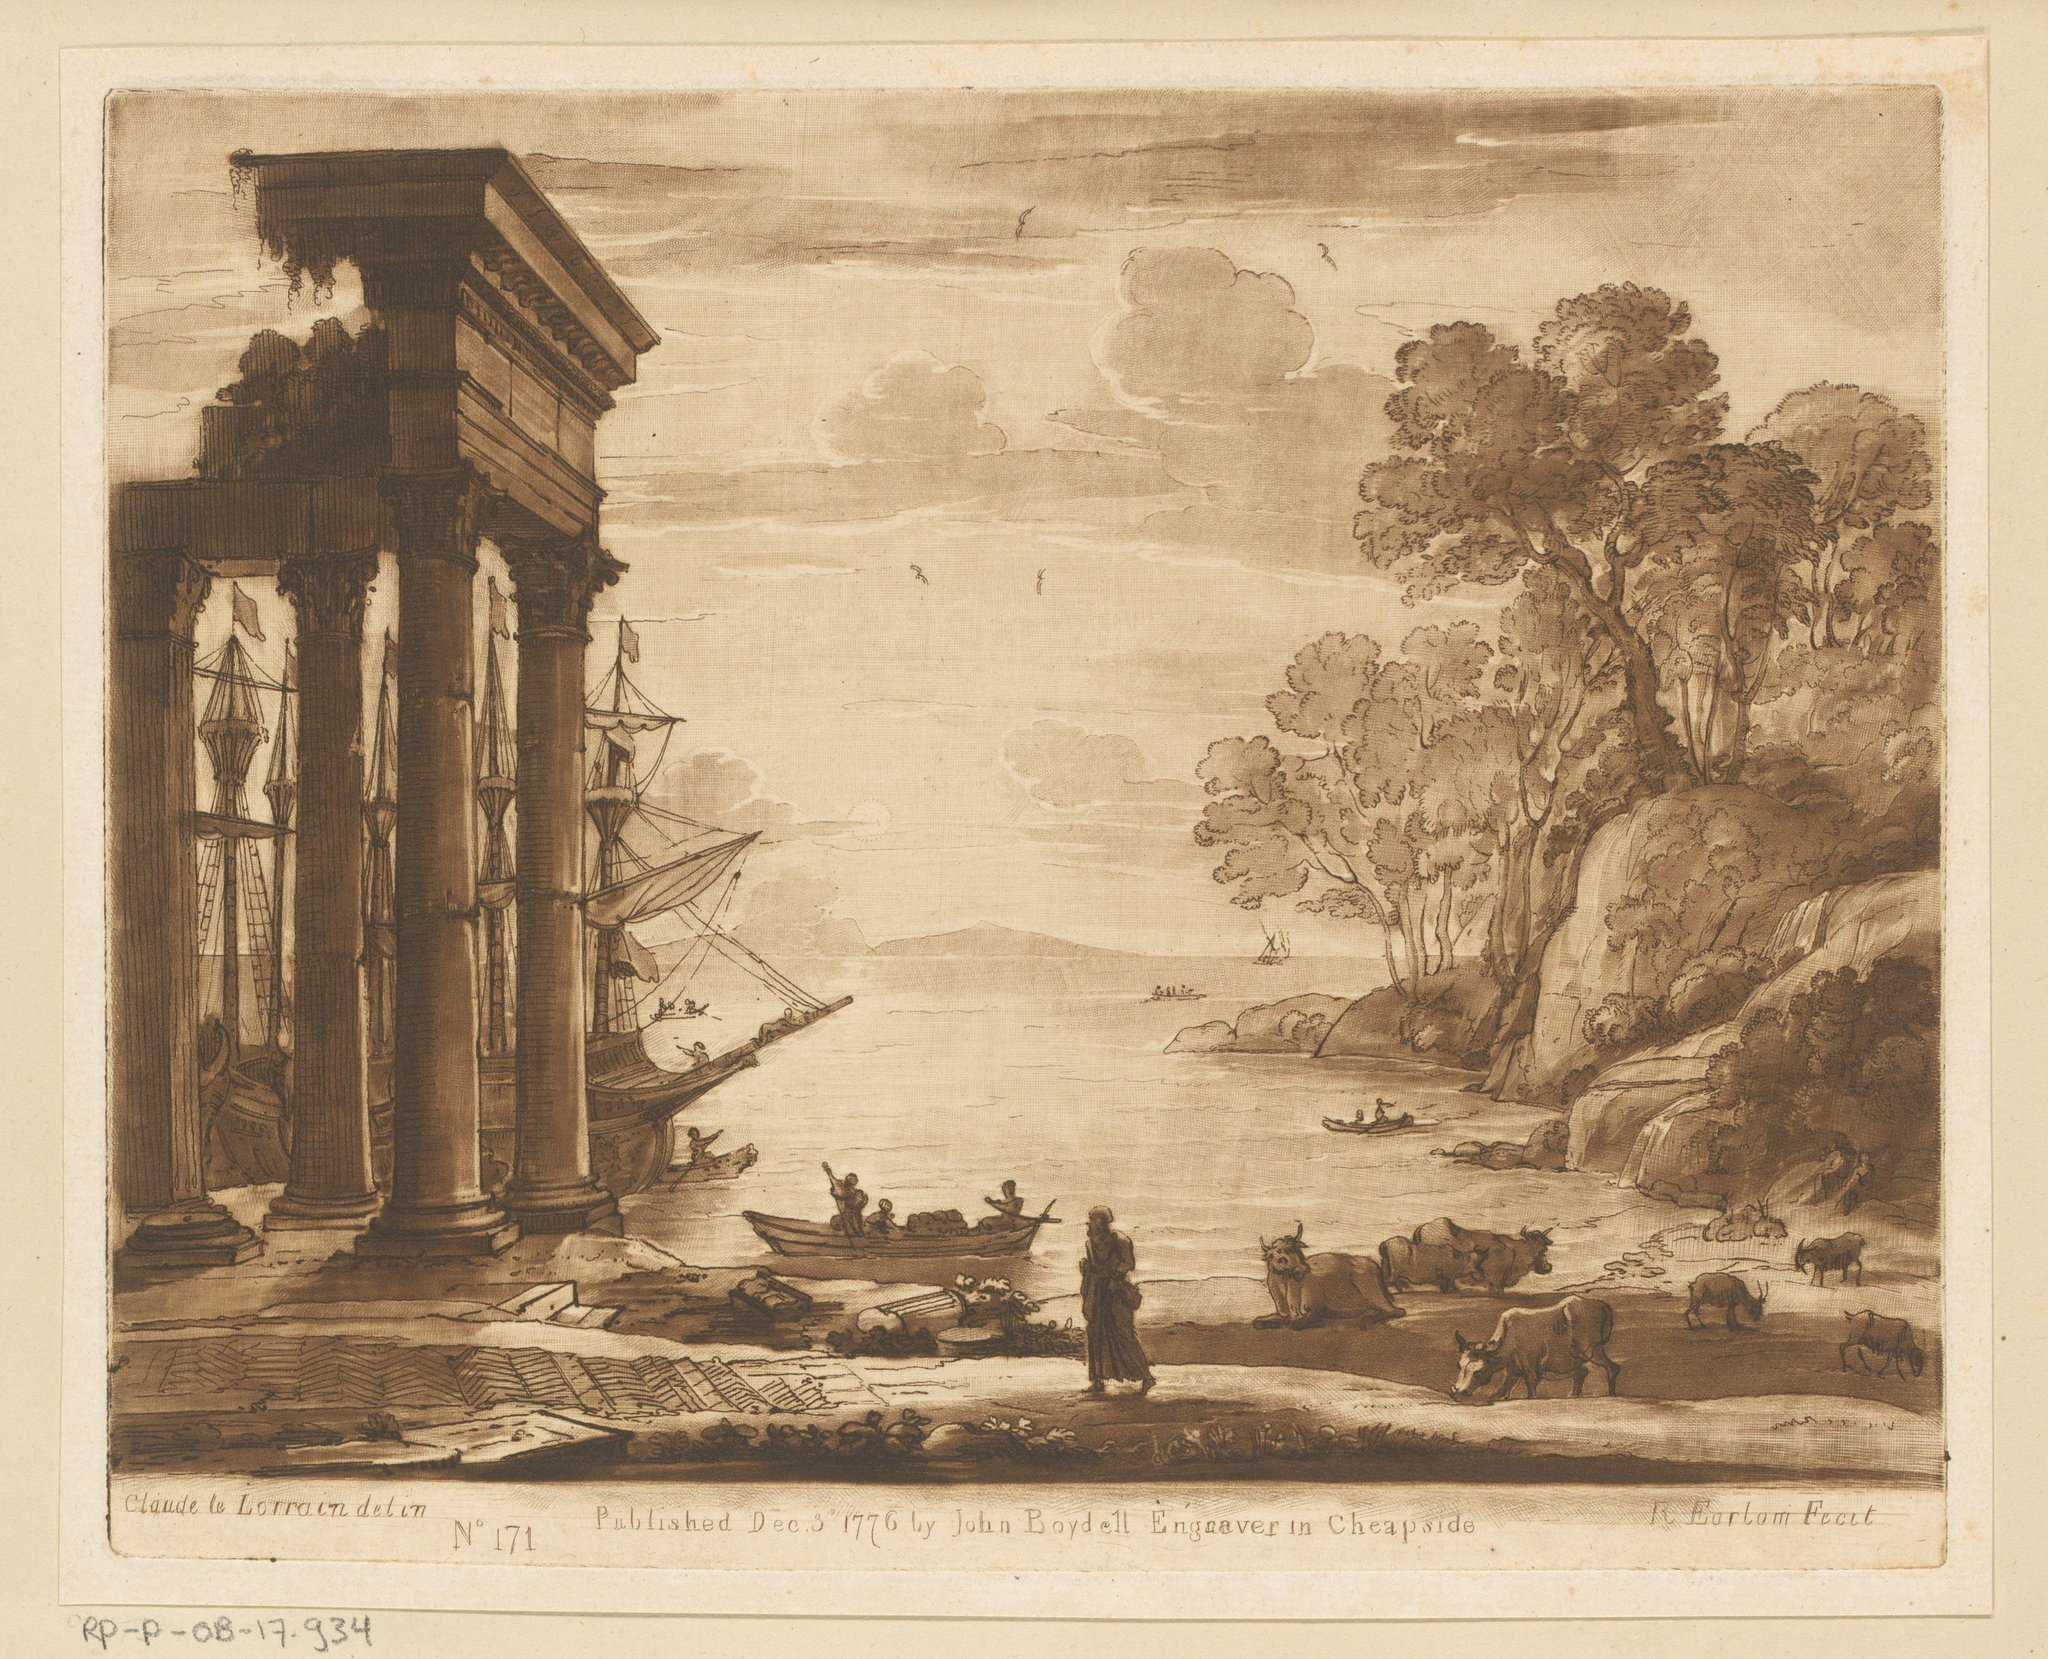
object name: print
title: Prenten naar tekeningen van Claude Lorrain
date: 1776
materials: paper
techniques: etching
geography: london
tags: sailing-ship, sailing-boat, coast - hh - ideal landscapes, cattle, ezekiel prophesies against tyrus (ezekiel 26-28), sea (seascape)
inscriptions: date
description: Vanaf 1774 publiceerde John Boydell tweehonderd prenten naar het tekeningenboek Liber Veritatis van Claude Lorrain, in het bezit van de hertogen van Cavendish. Deze prenten werden vanaf 1777 in twee volumes gebundeld uitgegeven.